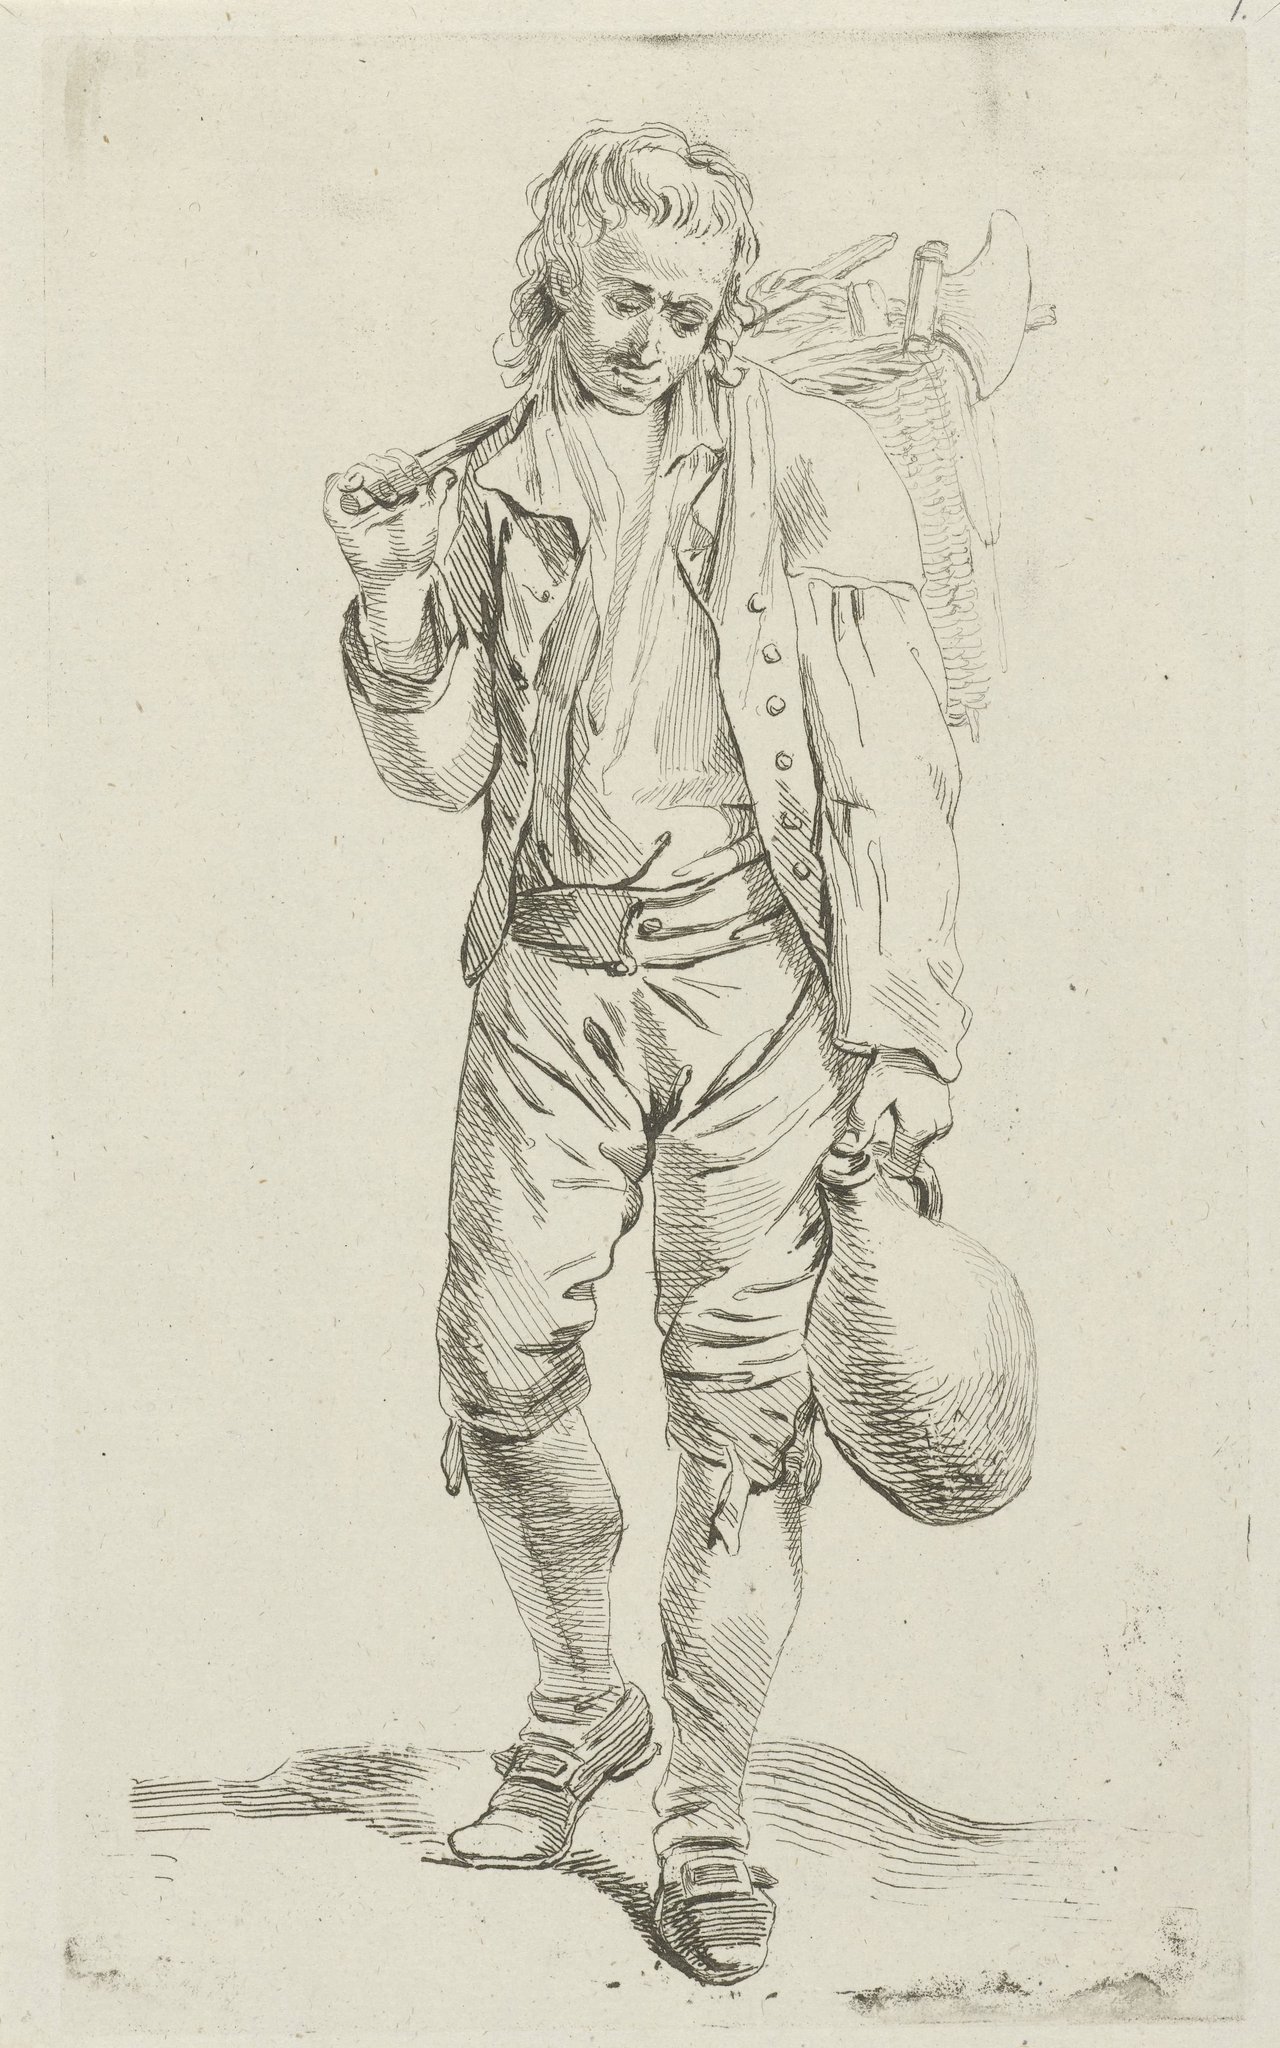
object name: print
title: Boer met kruik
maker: johannes pieter de frey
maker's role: draughtsman, print maker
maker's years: 1770-1834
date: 1770-1834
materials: paper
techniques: etching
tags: farmers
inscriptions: number: ‘1’, collector's mark: Lugt 12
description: Een boer, ten voeten uit, met een stenen kruik in zijn hand. Over zijn schouder draagt hij een stok waaraan een mand gevuld met gereedschap hangt. Deze prent maakt deel uit van een serie etsen door prentmaker J.P. de Frey naar tekeningen van J. Lauwers.